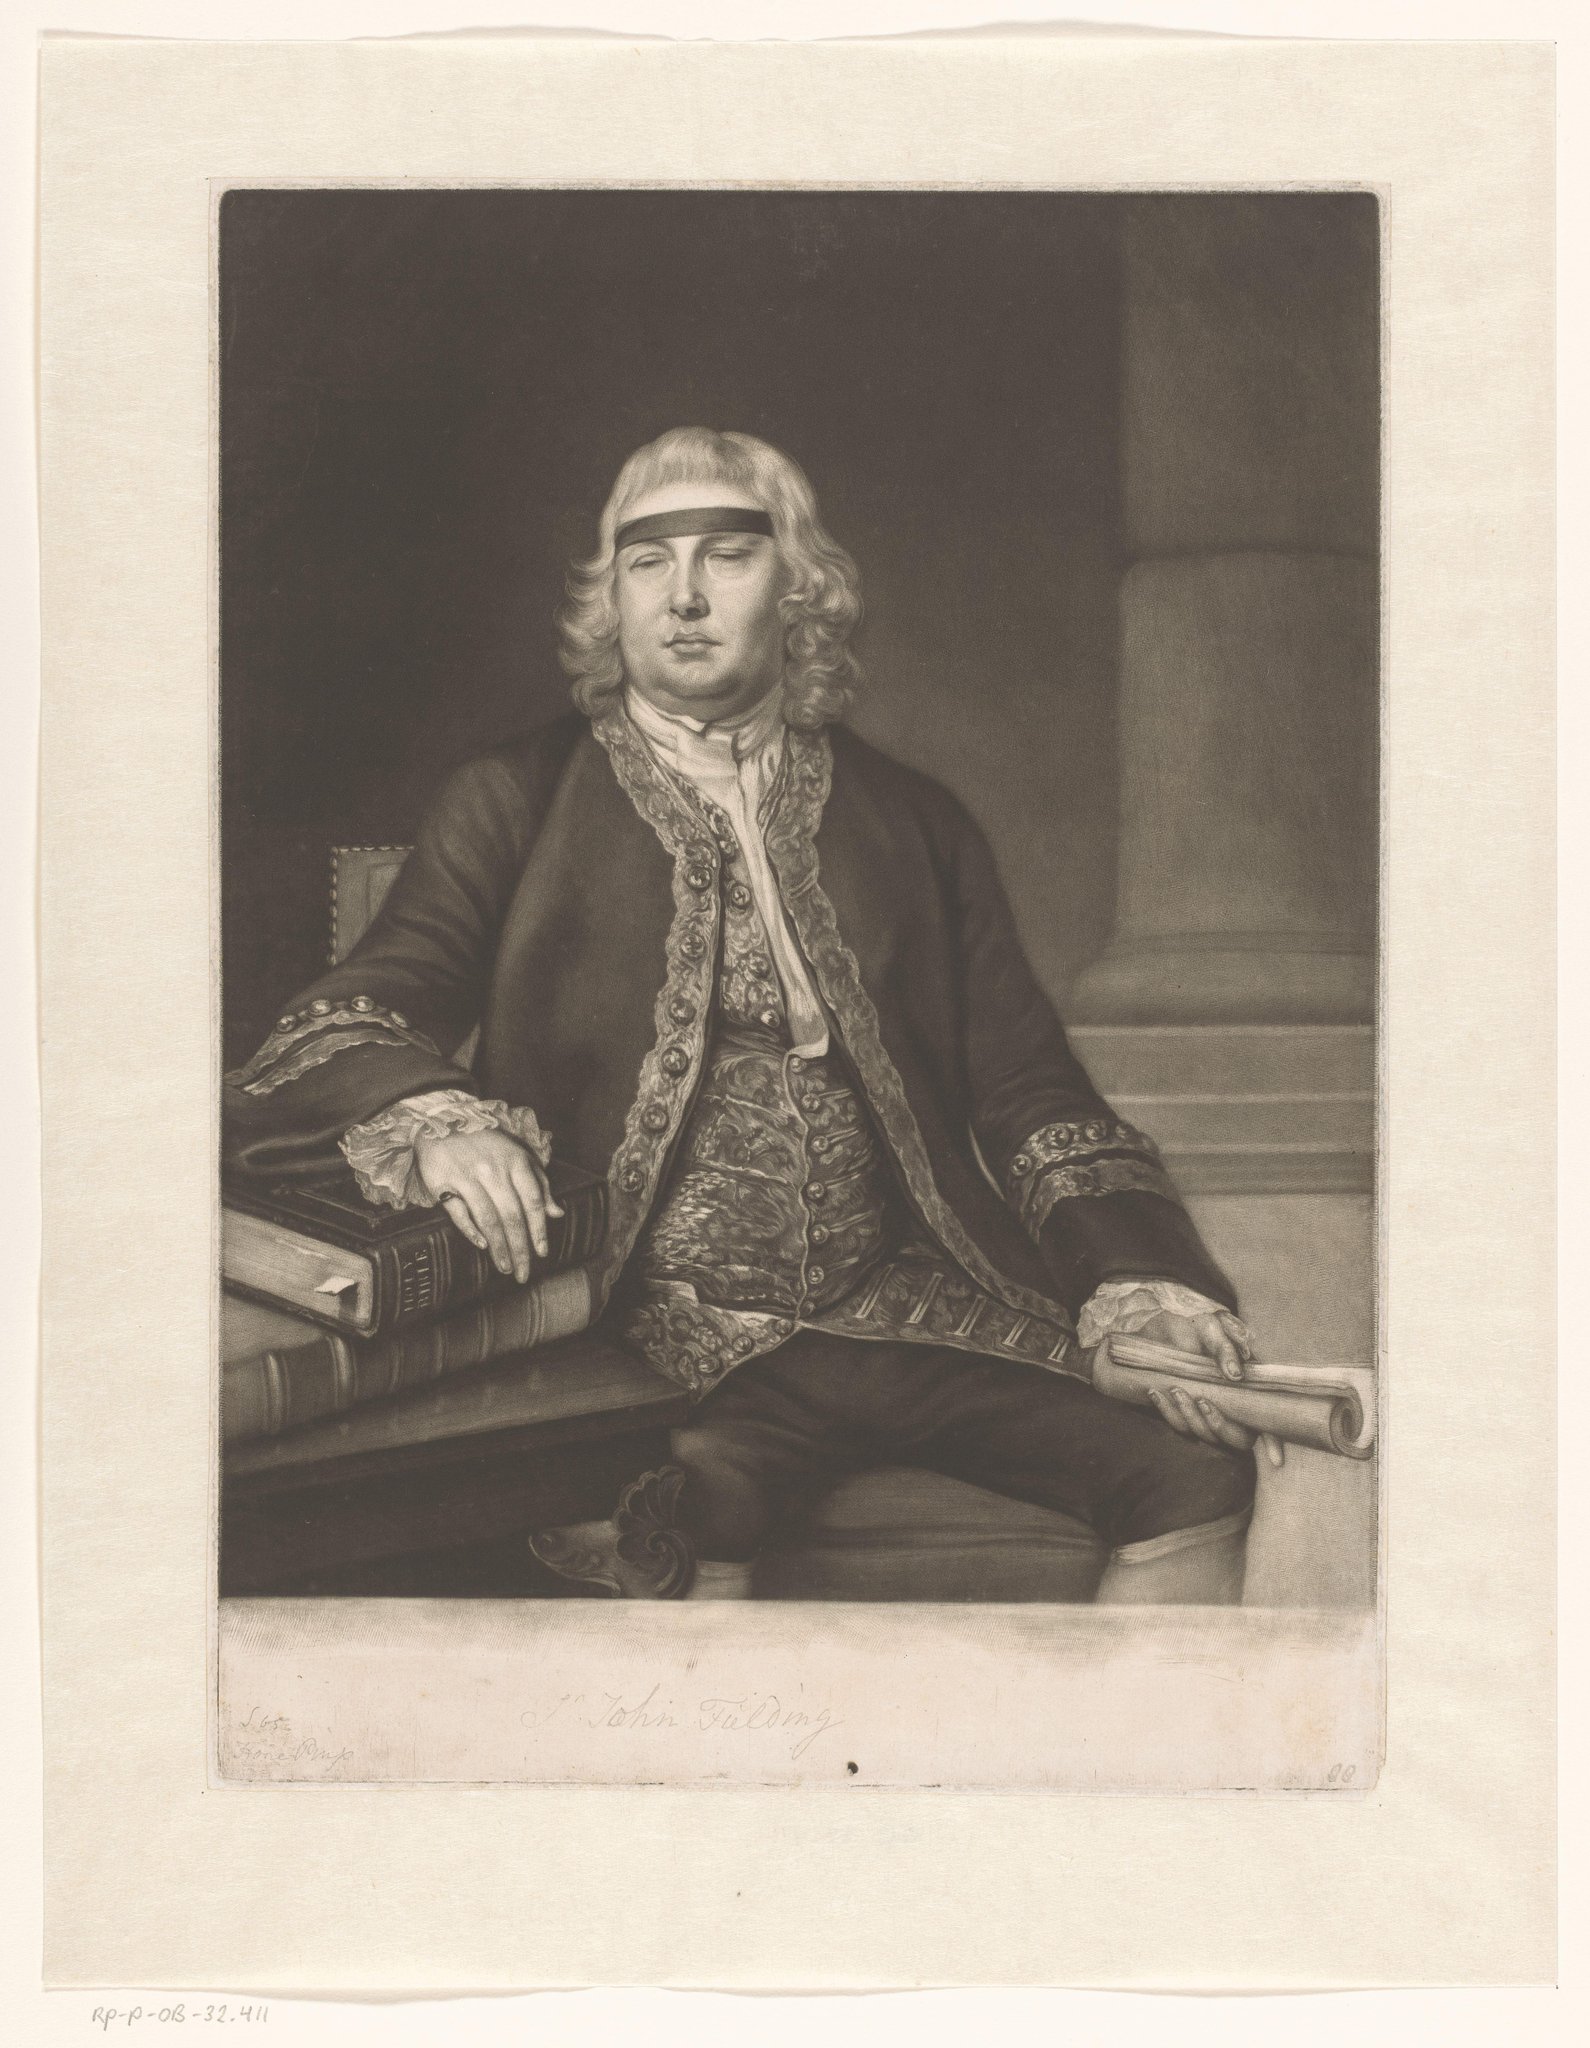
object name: print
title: Portret van John Fielding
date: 1762-1765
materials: paper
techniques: mezzotint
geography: london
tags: historical persons, magistracy, judges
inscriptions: collector's mark: Lugt 240